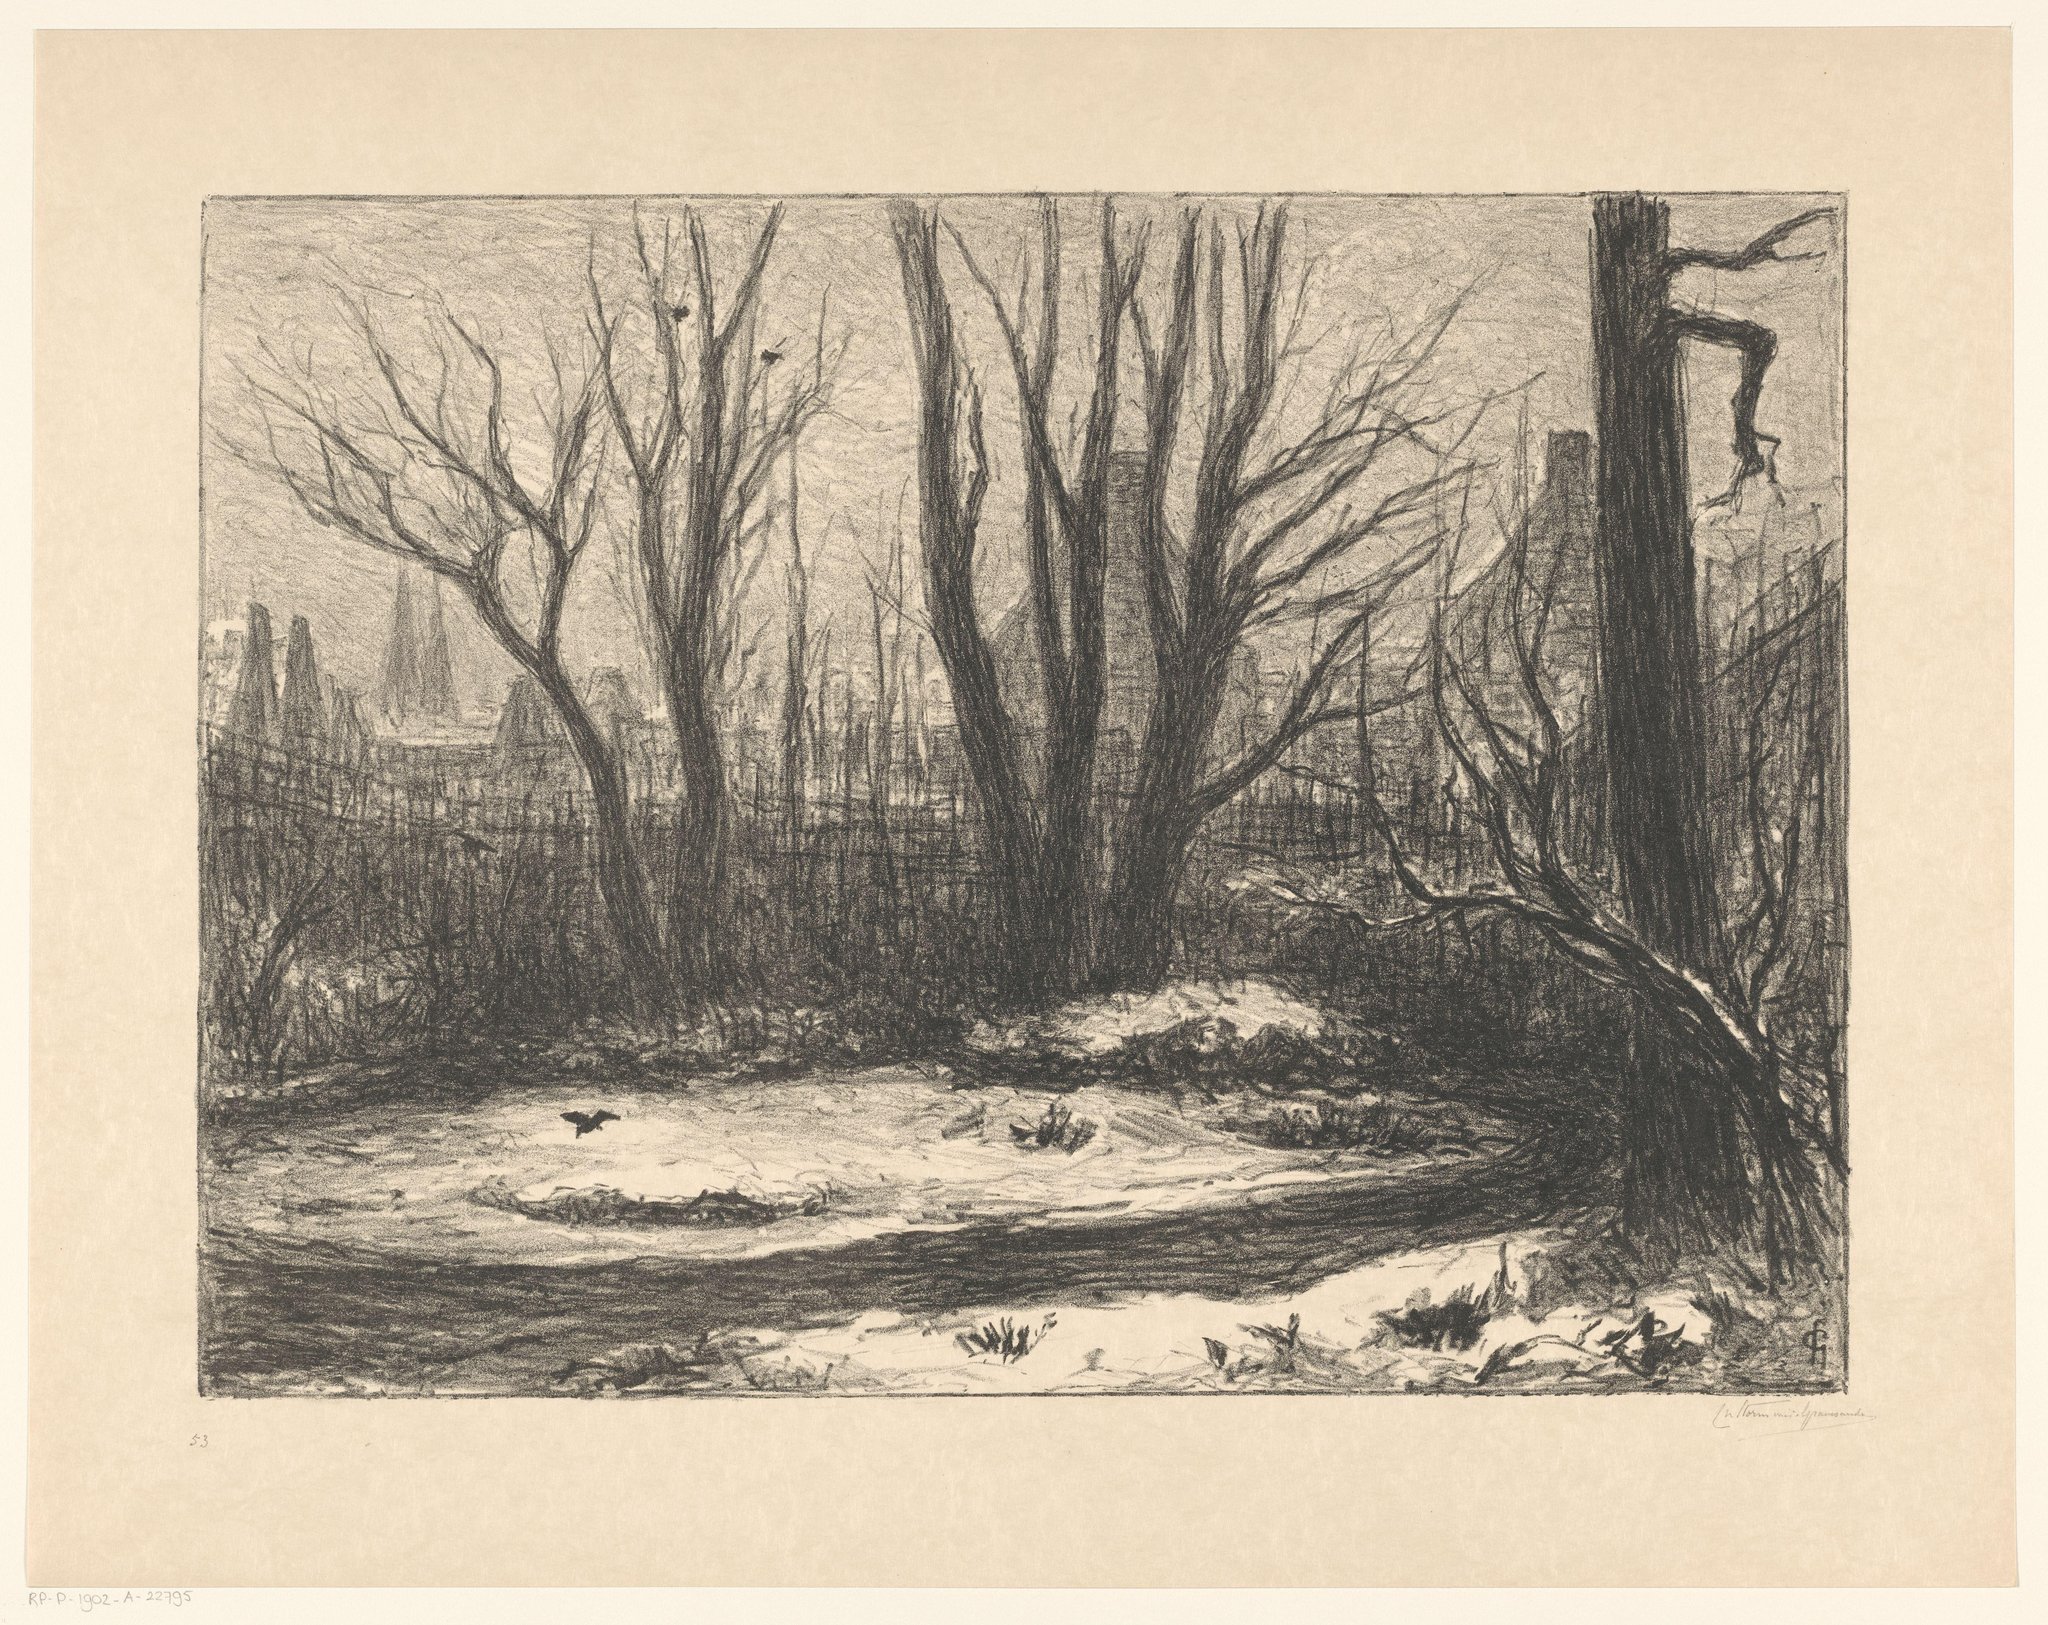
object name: print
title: Besneeuwde tuin te Deventer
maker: carel nicolaas storm van s-gravesande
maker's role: draughtsman, print maker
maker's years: 1841-1924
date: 1851-1902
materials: paper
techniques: lithograph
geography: netherlands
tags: winter, 'hyems'; 'inverno' (ripa), garden, deventer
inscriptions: collector's mark: Lugt 2228